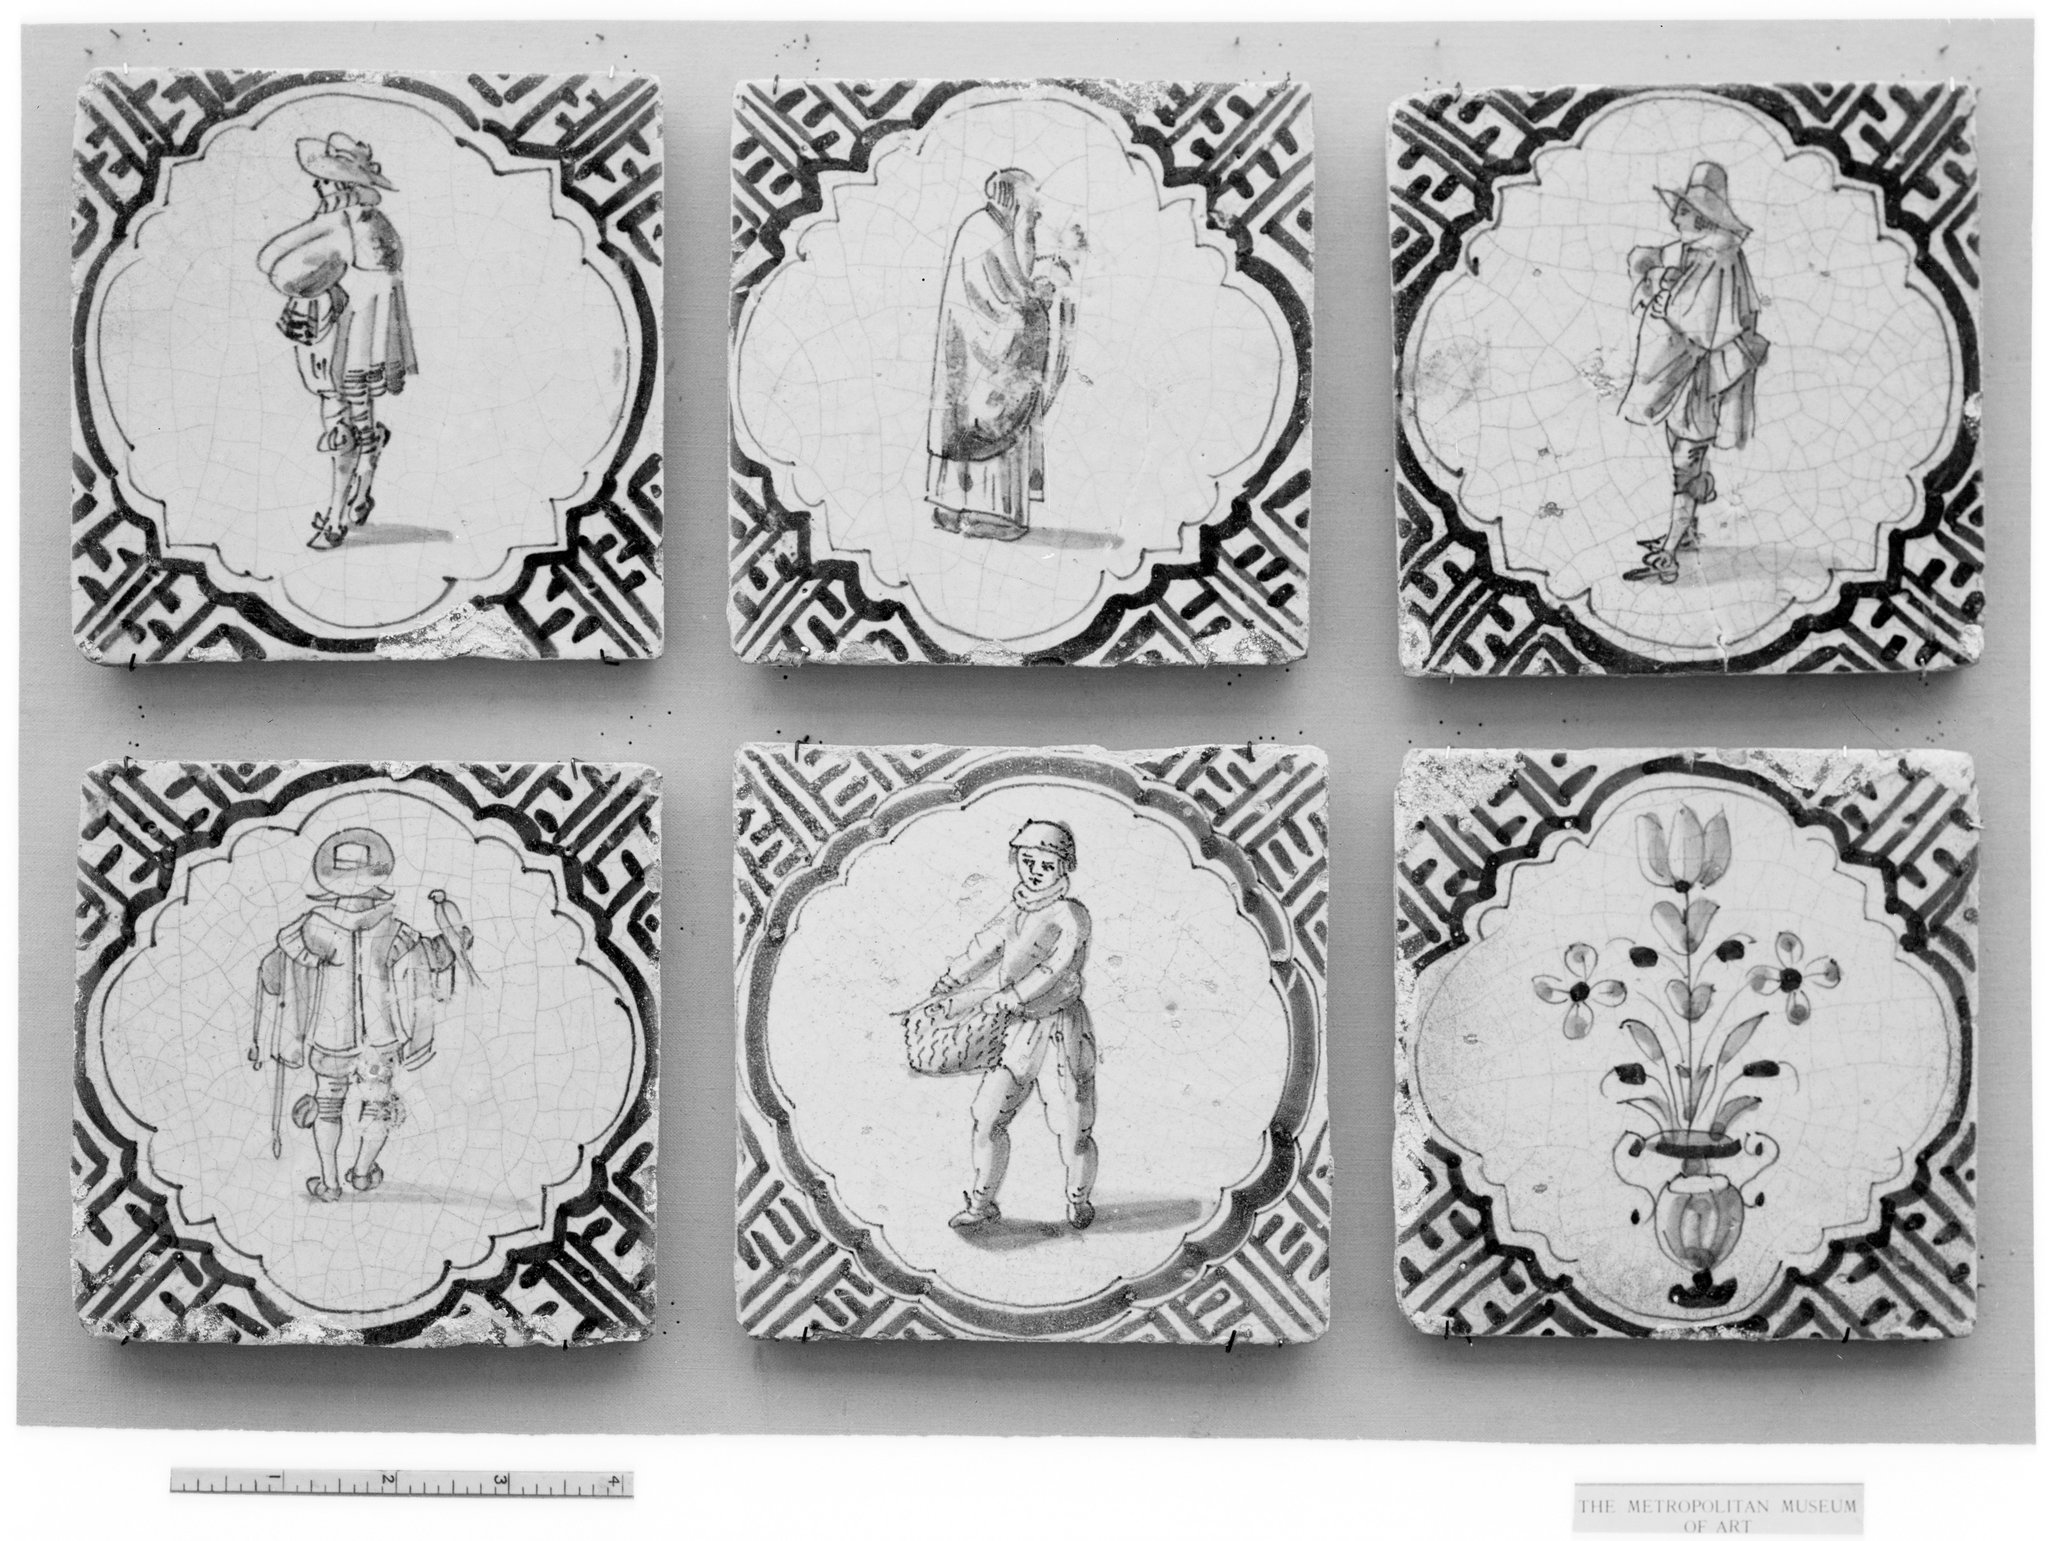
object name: tile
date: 1620-1640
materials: earthenware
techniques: glazing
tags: men,flowers